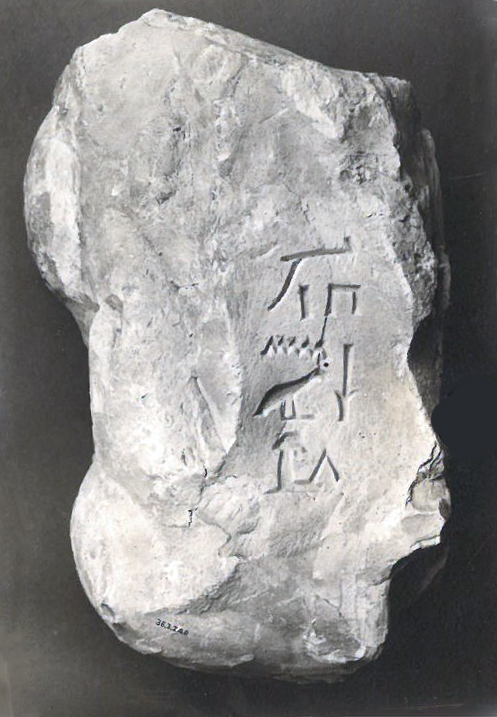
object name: name stone, tally, senenmut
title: Name Stone of Senenmut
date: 1479-1458 BCE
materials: limestone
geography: egypt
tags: hieroglyphs